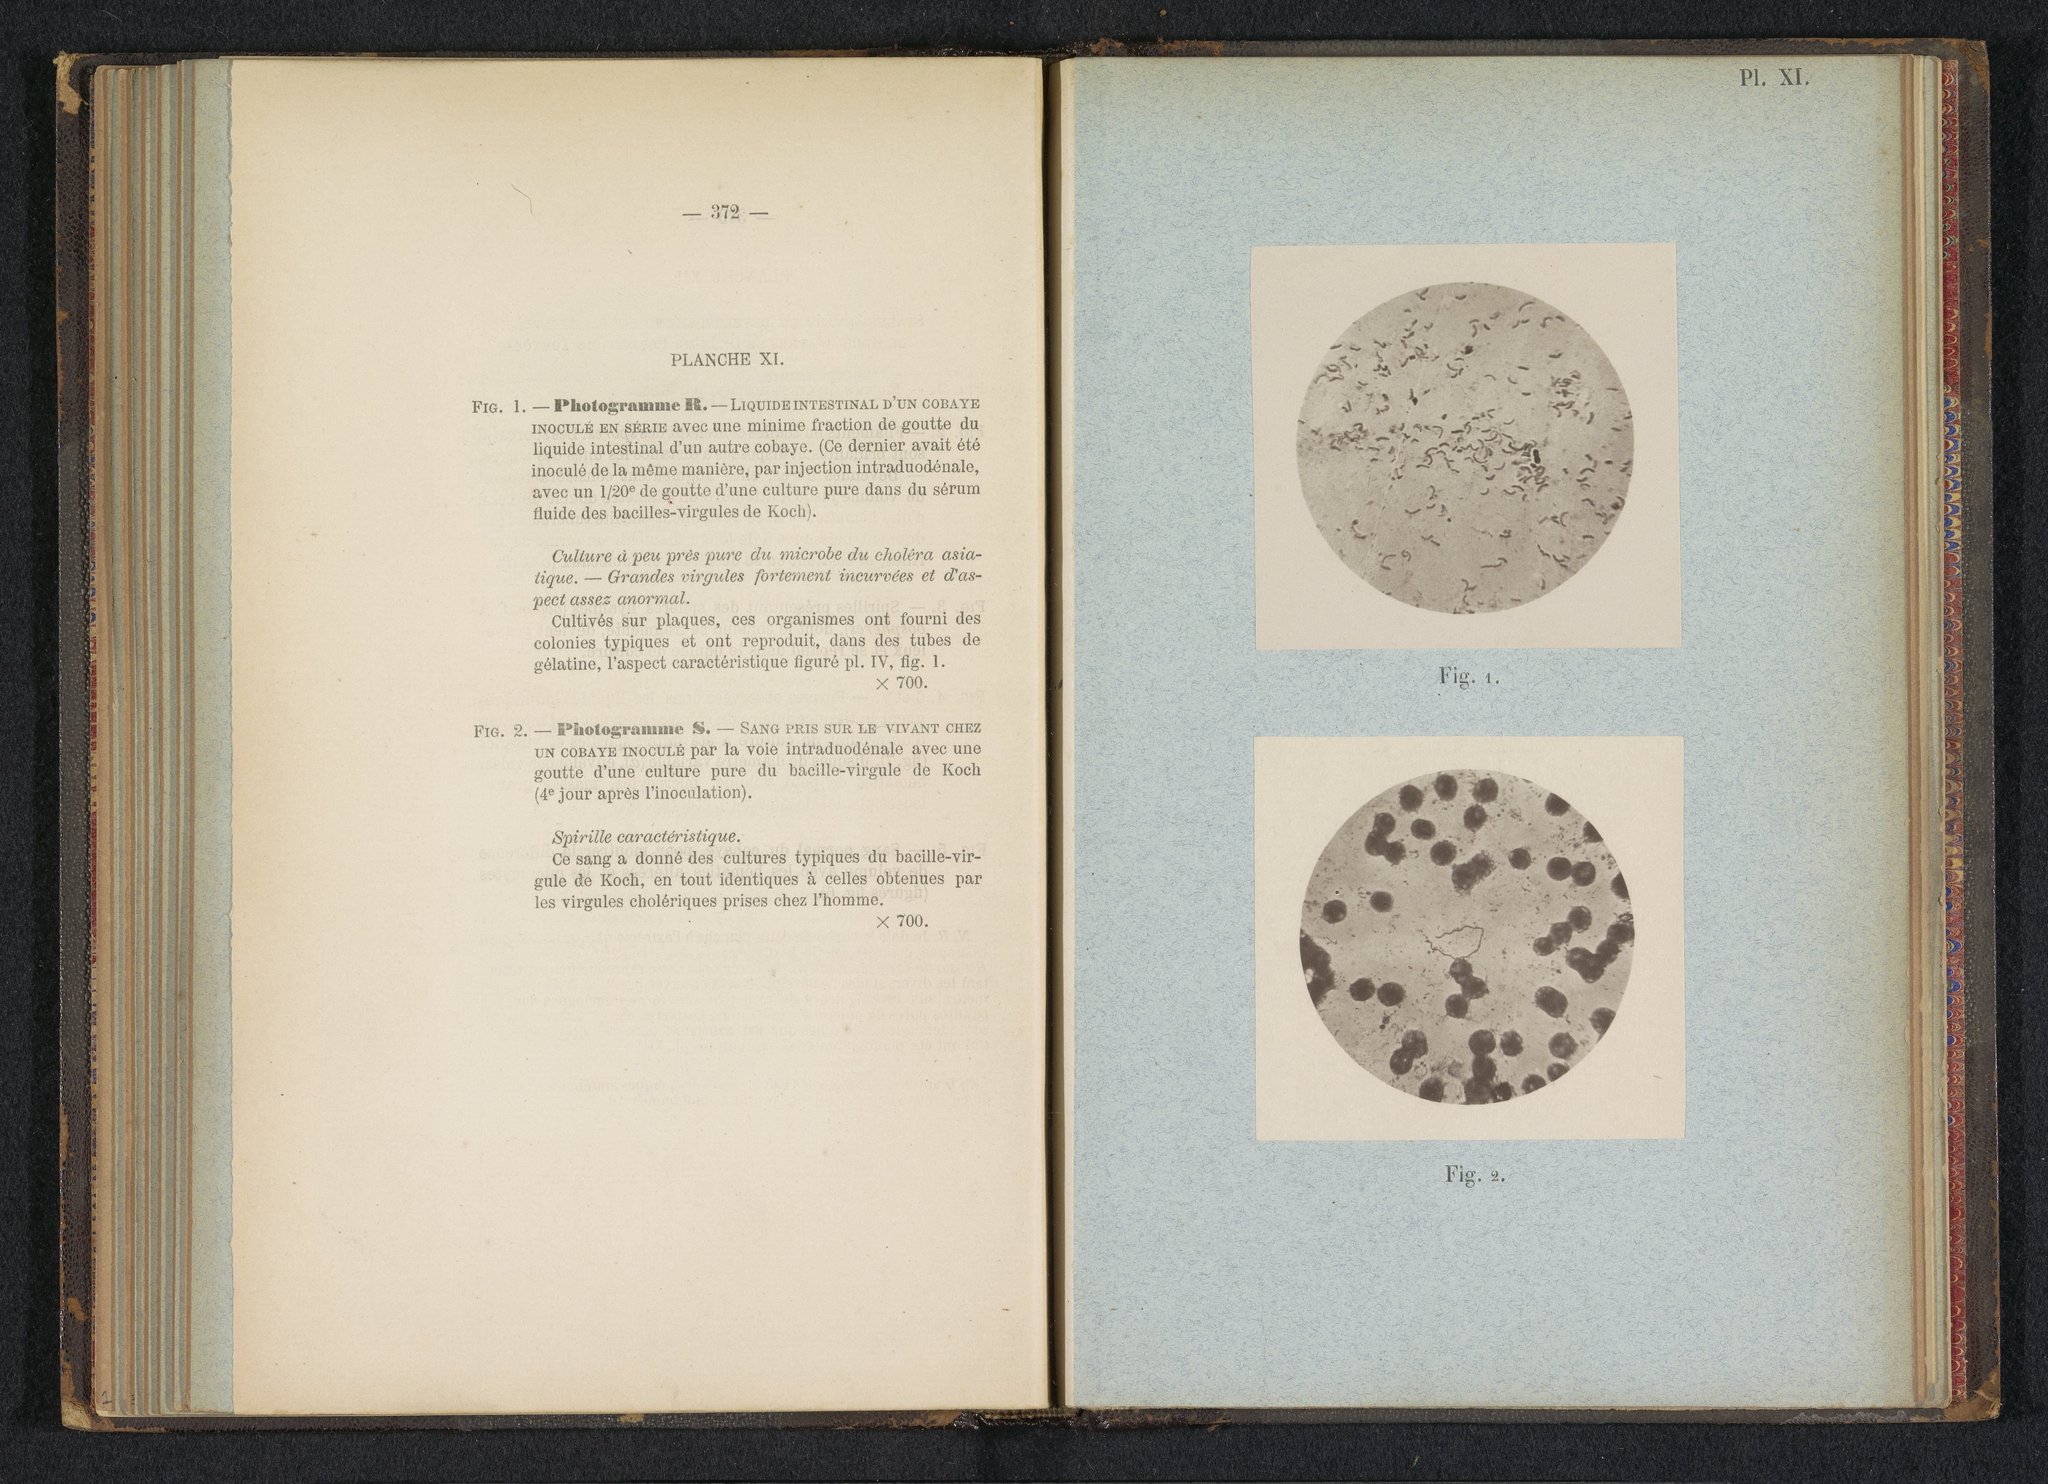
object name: page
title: Twee microscoopopnamen van darmsap en bloed van een cavia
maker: émile van ermengem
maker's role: bioloog, fotograaf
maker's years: 1851-1932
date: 1875-1885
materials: photographic support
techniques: carbon print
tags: diseases affecting the whole body, microscope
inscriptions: number: ‘Pl. XI. Fig. 1. Fig. 2.’, inscription: ‘Fig. 1.- Photogramme R. Liquide intestinal d'un cobaye inoculé en série avec une minime fraction de goutte du liquide intestinal d'un autre cobaye. (...) Fig. 2. - Photogramme S.- Sang pris sur le vivant chez un cobaye inoculé par la voie intraduodénale avec une goutte d'une culture pure du bacille-virgule de Koch (...)’